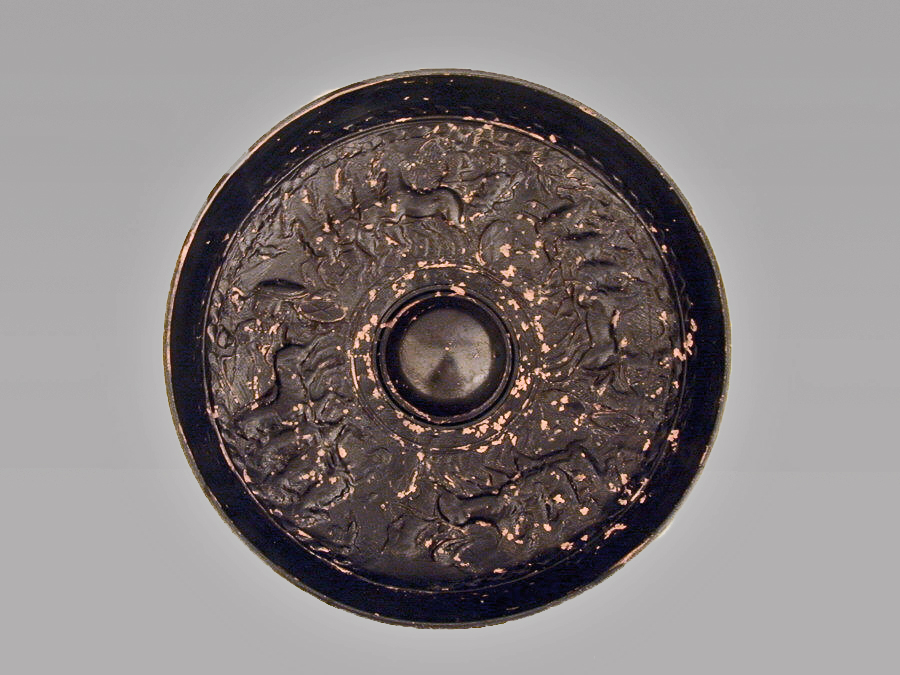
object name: phiale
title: Terracotta phiale (libation bowl)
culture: greek, calenian or campanian or south italian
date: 300-201 BCE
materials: terracotta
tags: nike,horses,chariots